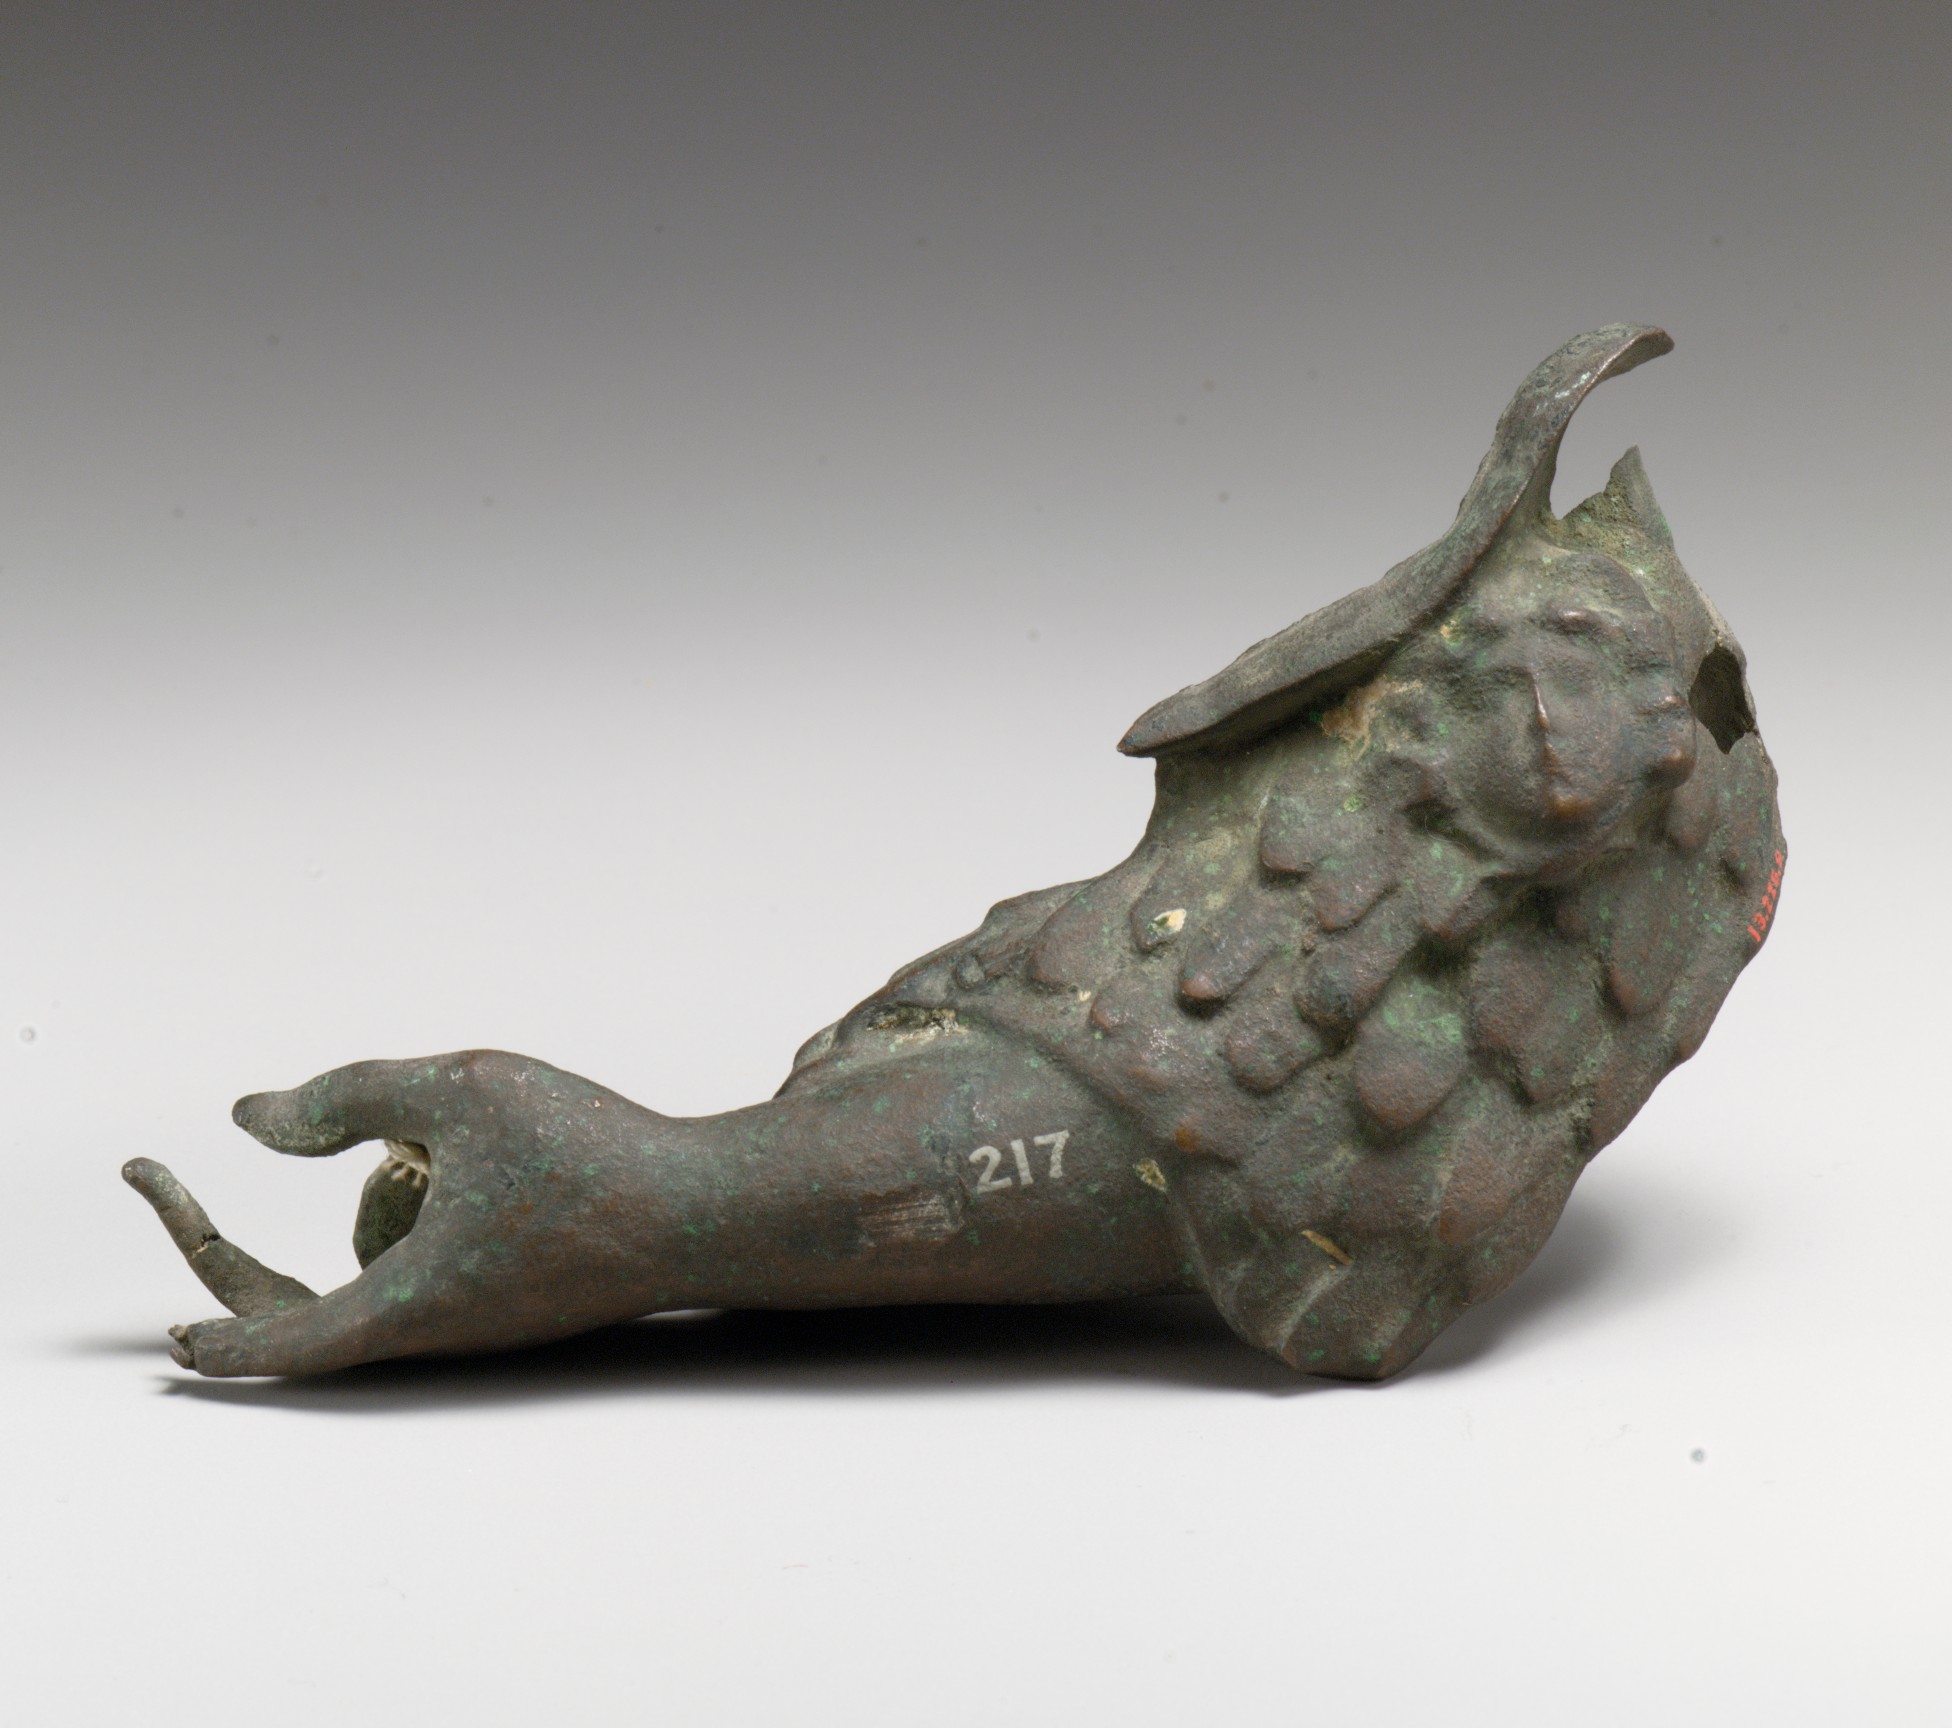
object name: arm and hand of athena, fragment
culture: roman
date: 670 BCE-330 CE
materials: bronze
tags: hands,athena